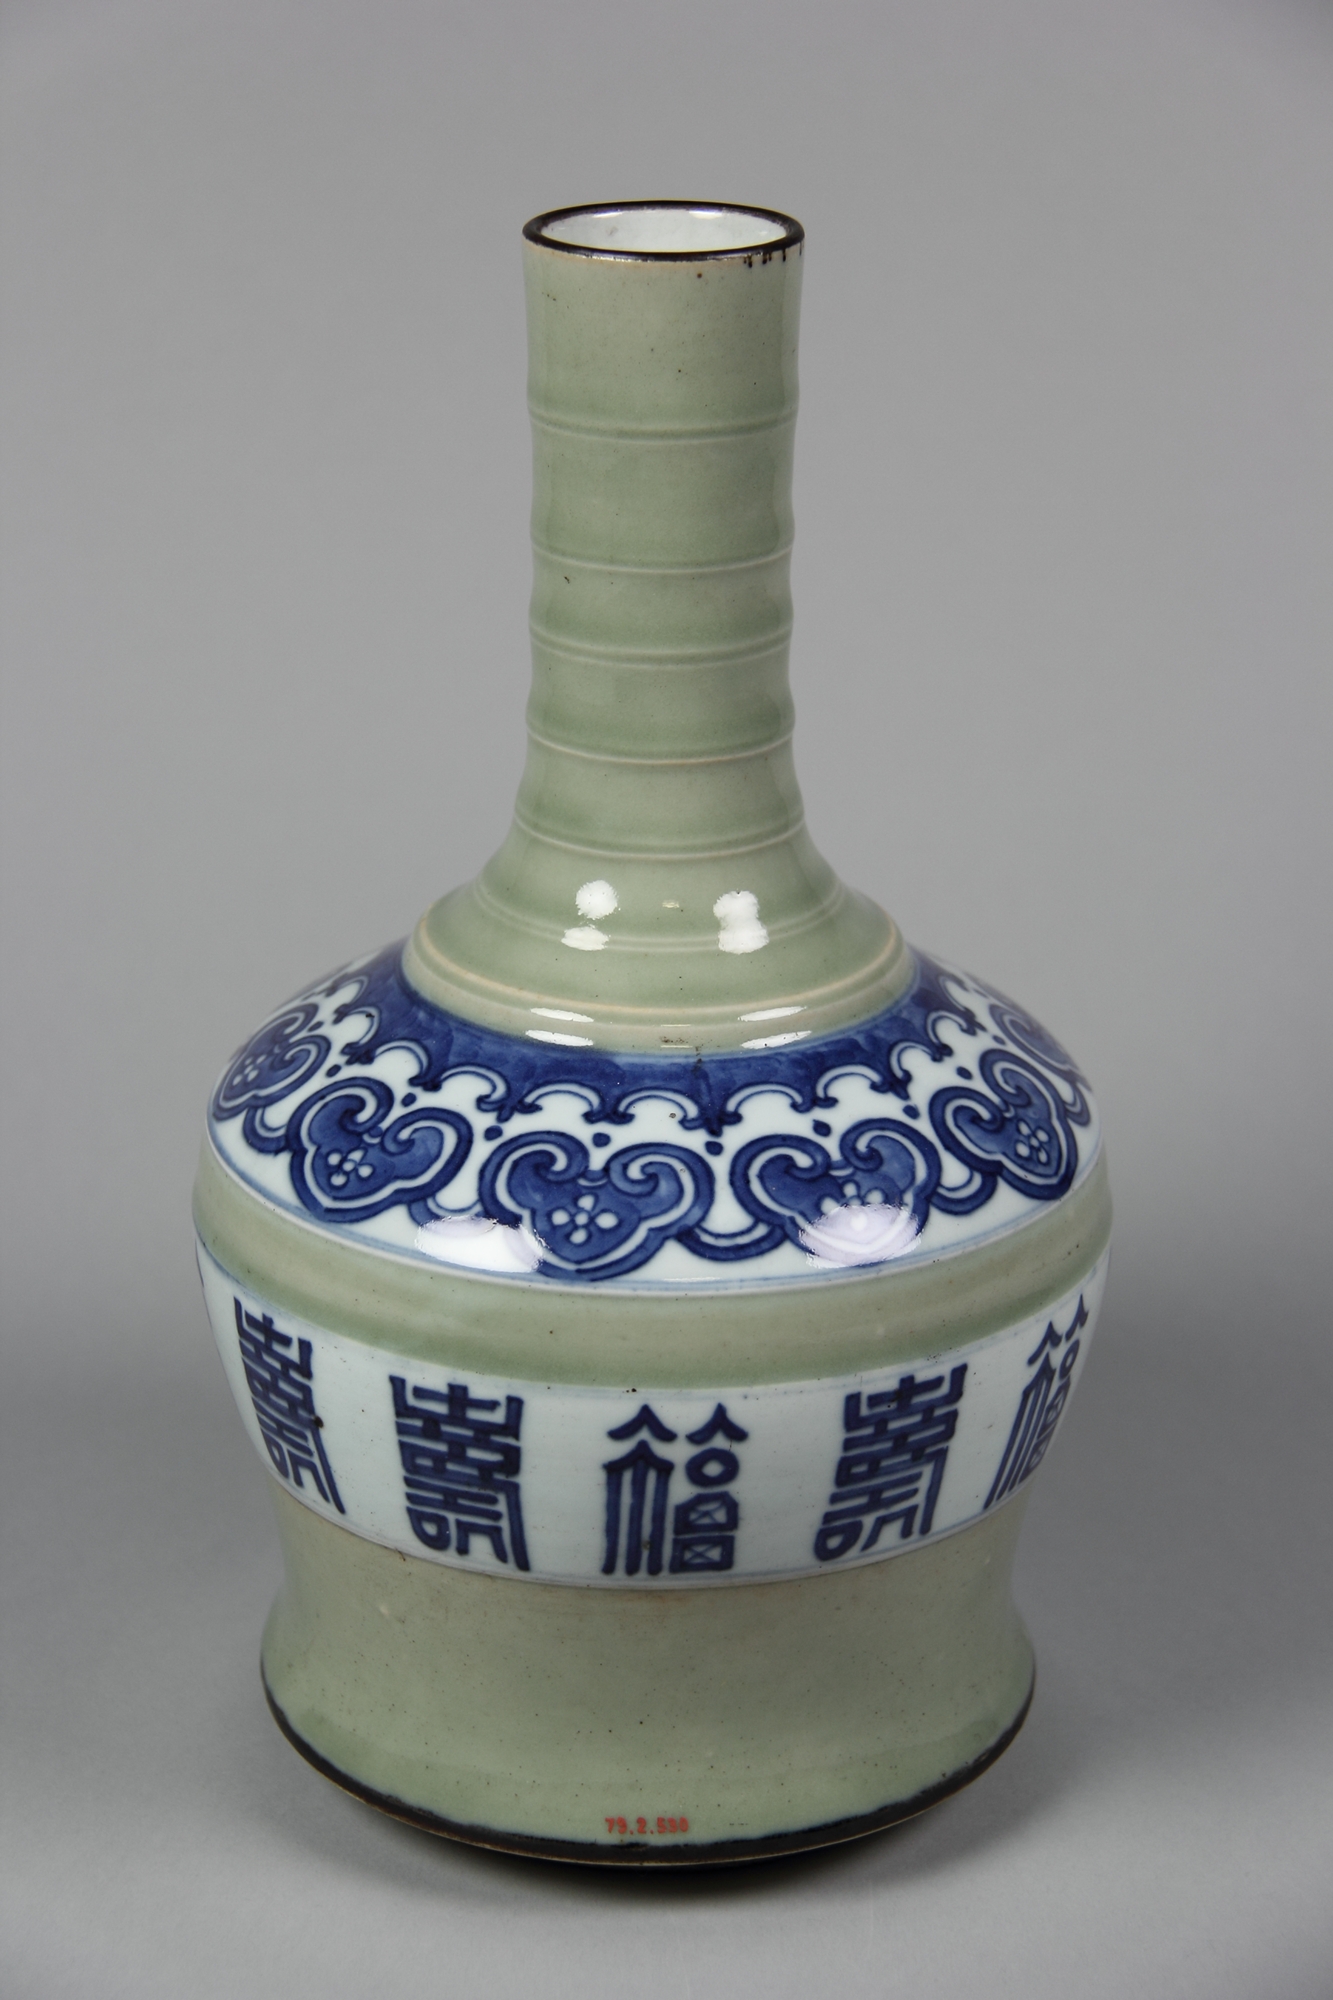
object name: vase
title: Vase with characters fortune (fu) and longevity (shou)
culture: chinese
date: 1801-1850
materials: ceramic glaze, cobalt, glaze, porcelain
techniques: painting, underglaze